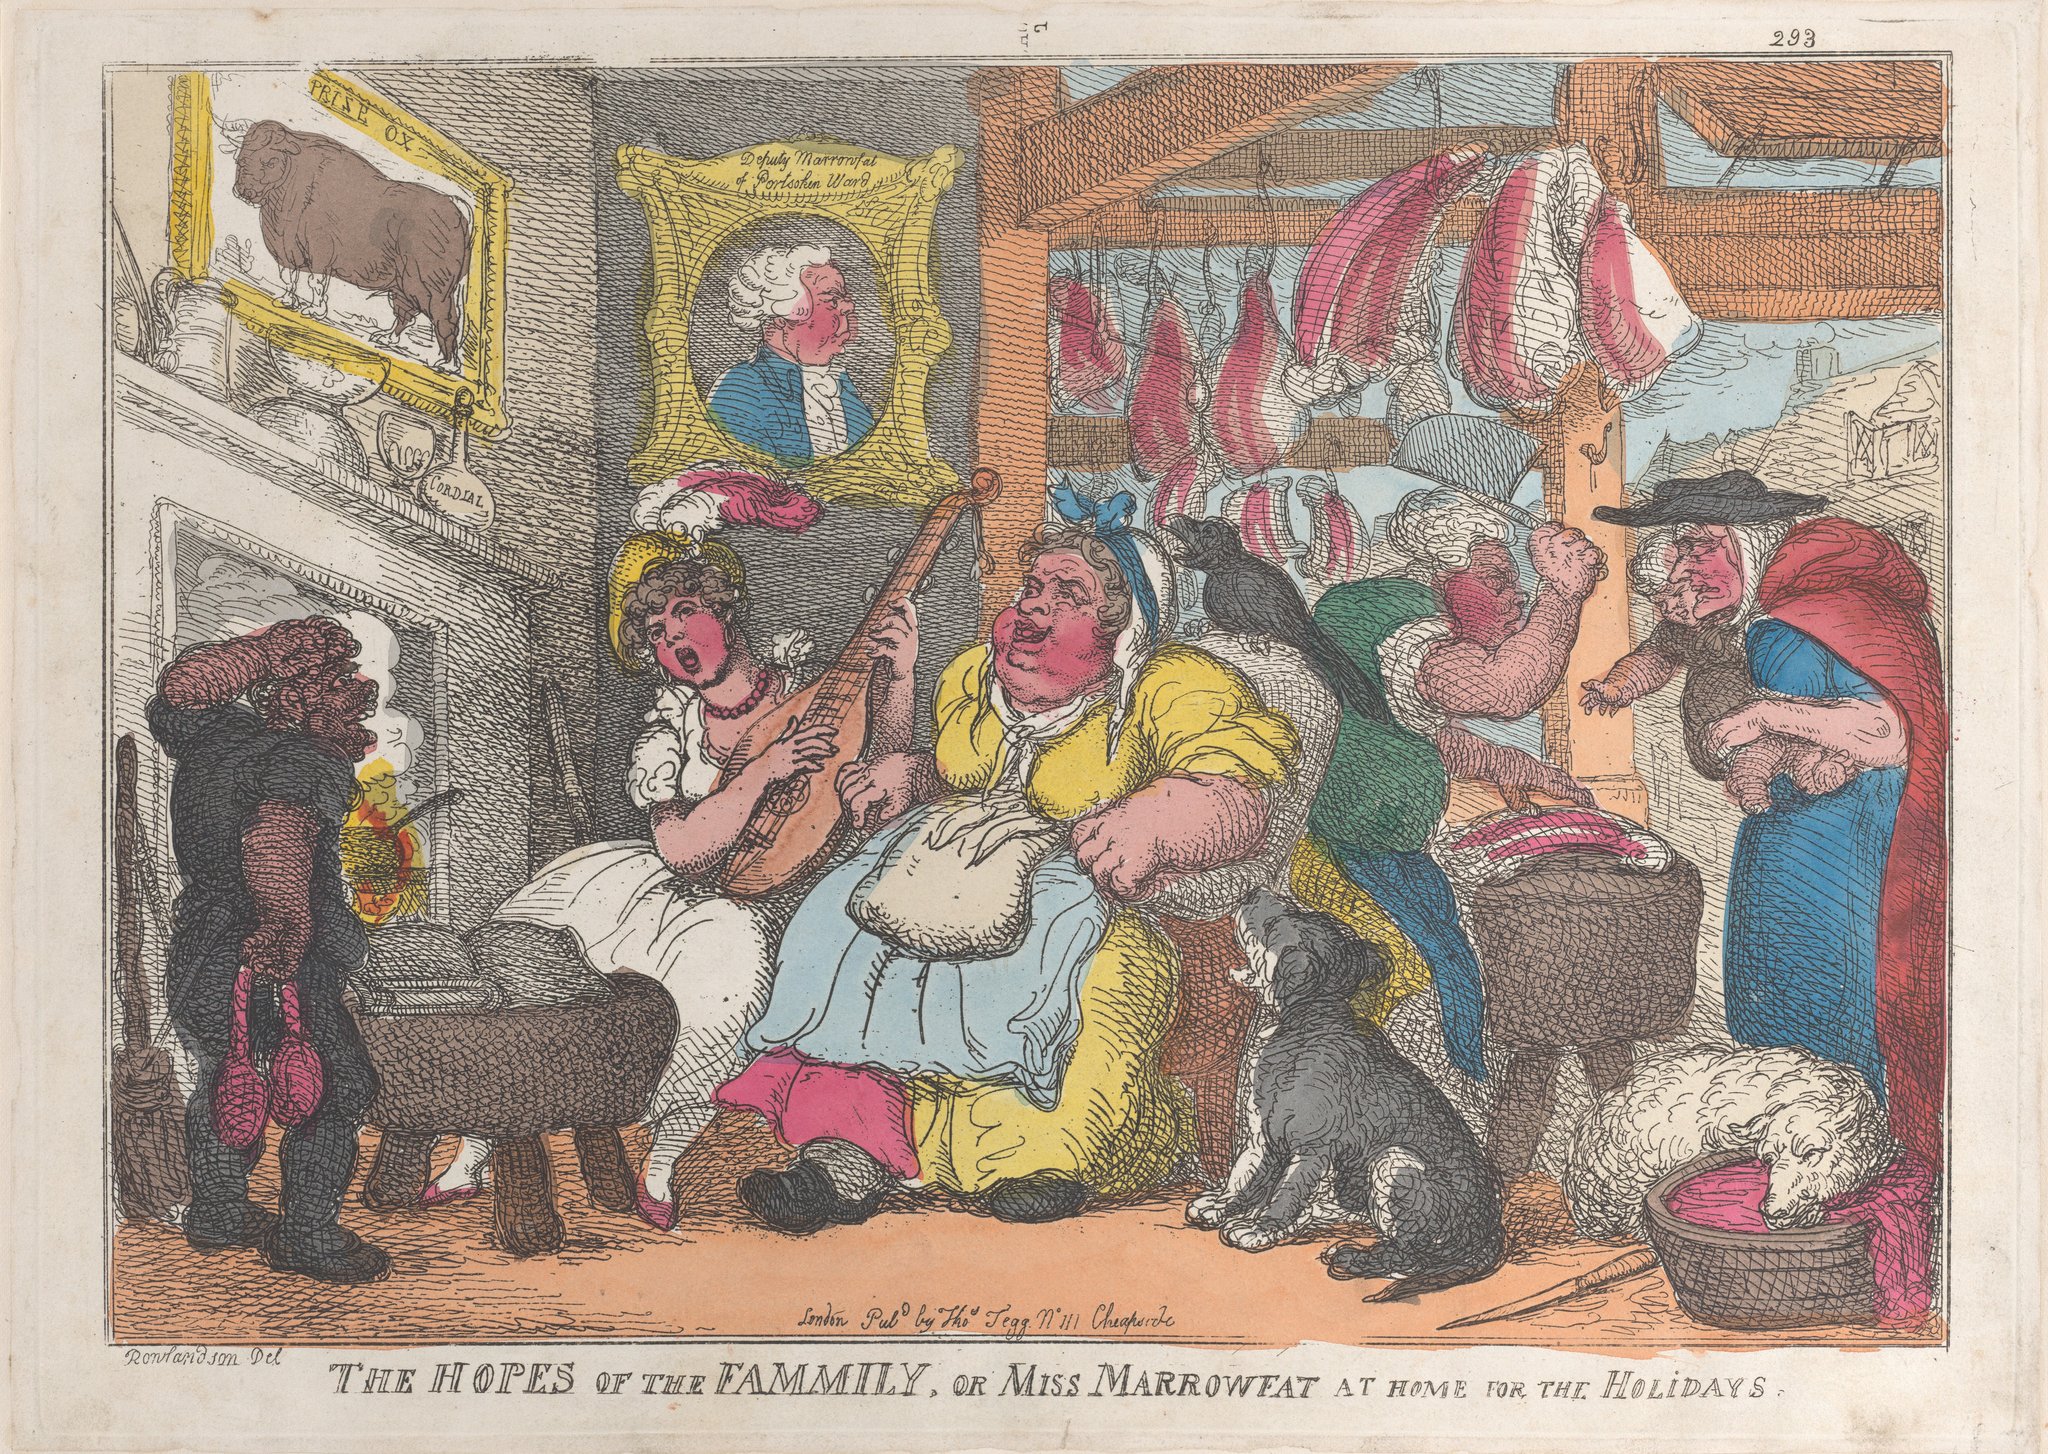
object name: print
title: The Hopes of the Family, or Miss Marrowfat at Home for the Holidays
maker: thomas rowlandson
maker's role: artist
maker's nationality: british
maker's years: 1757-1827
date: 1809-1813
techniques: etching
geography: london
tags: satire,men,women,dogs,butchers,musicians